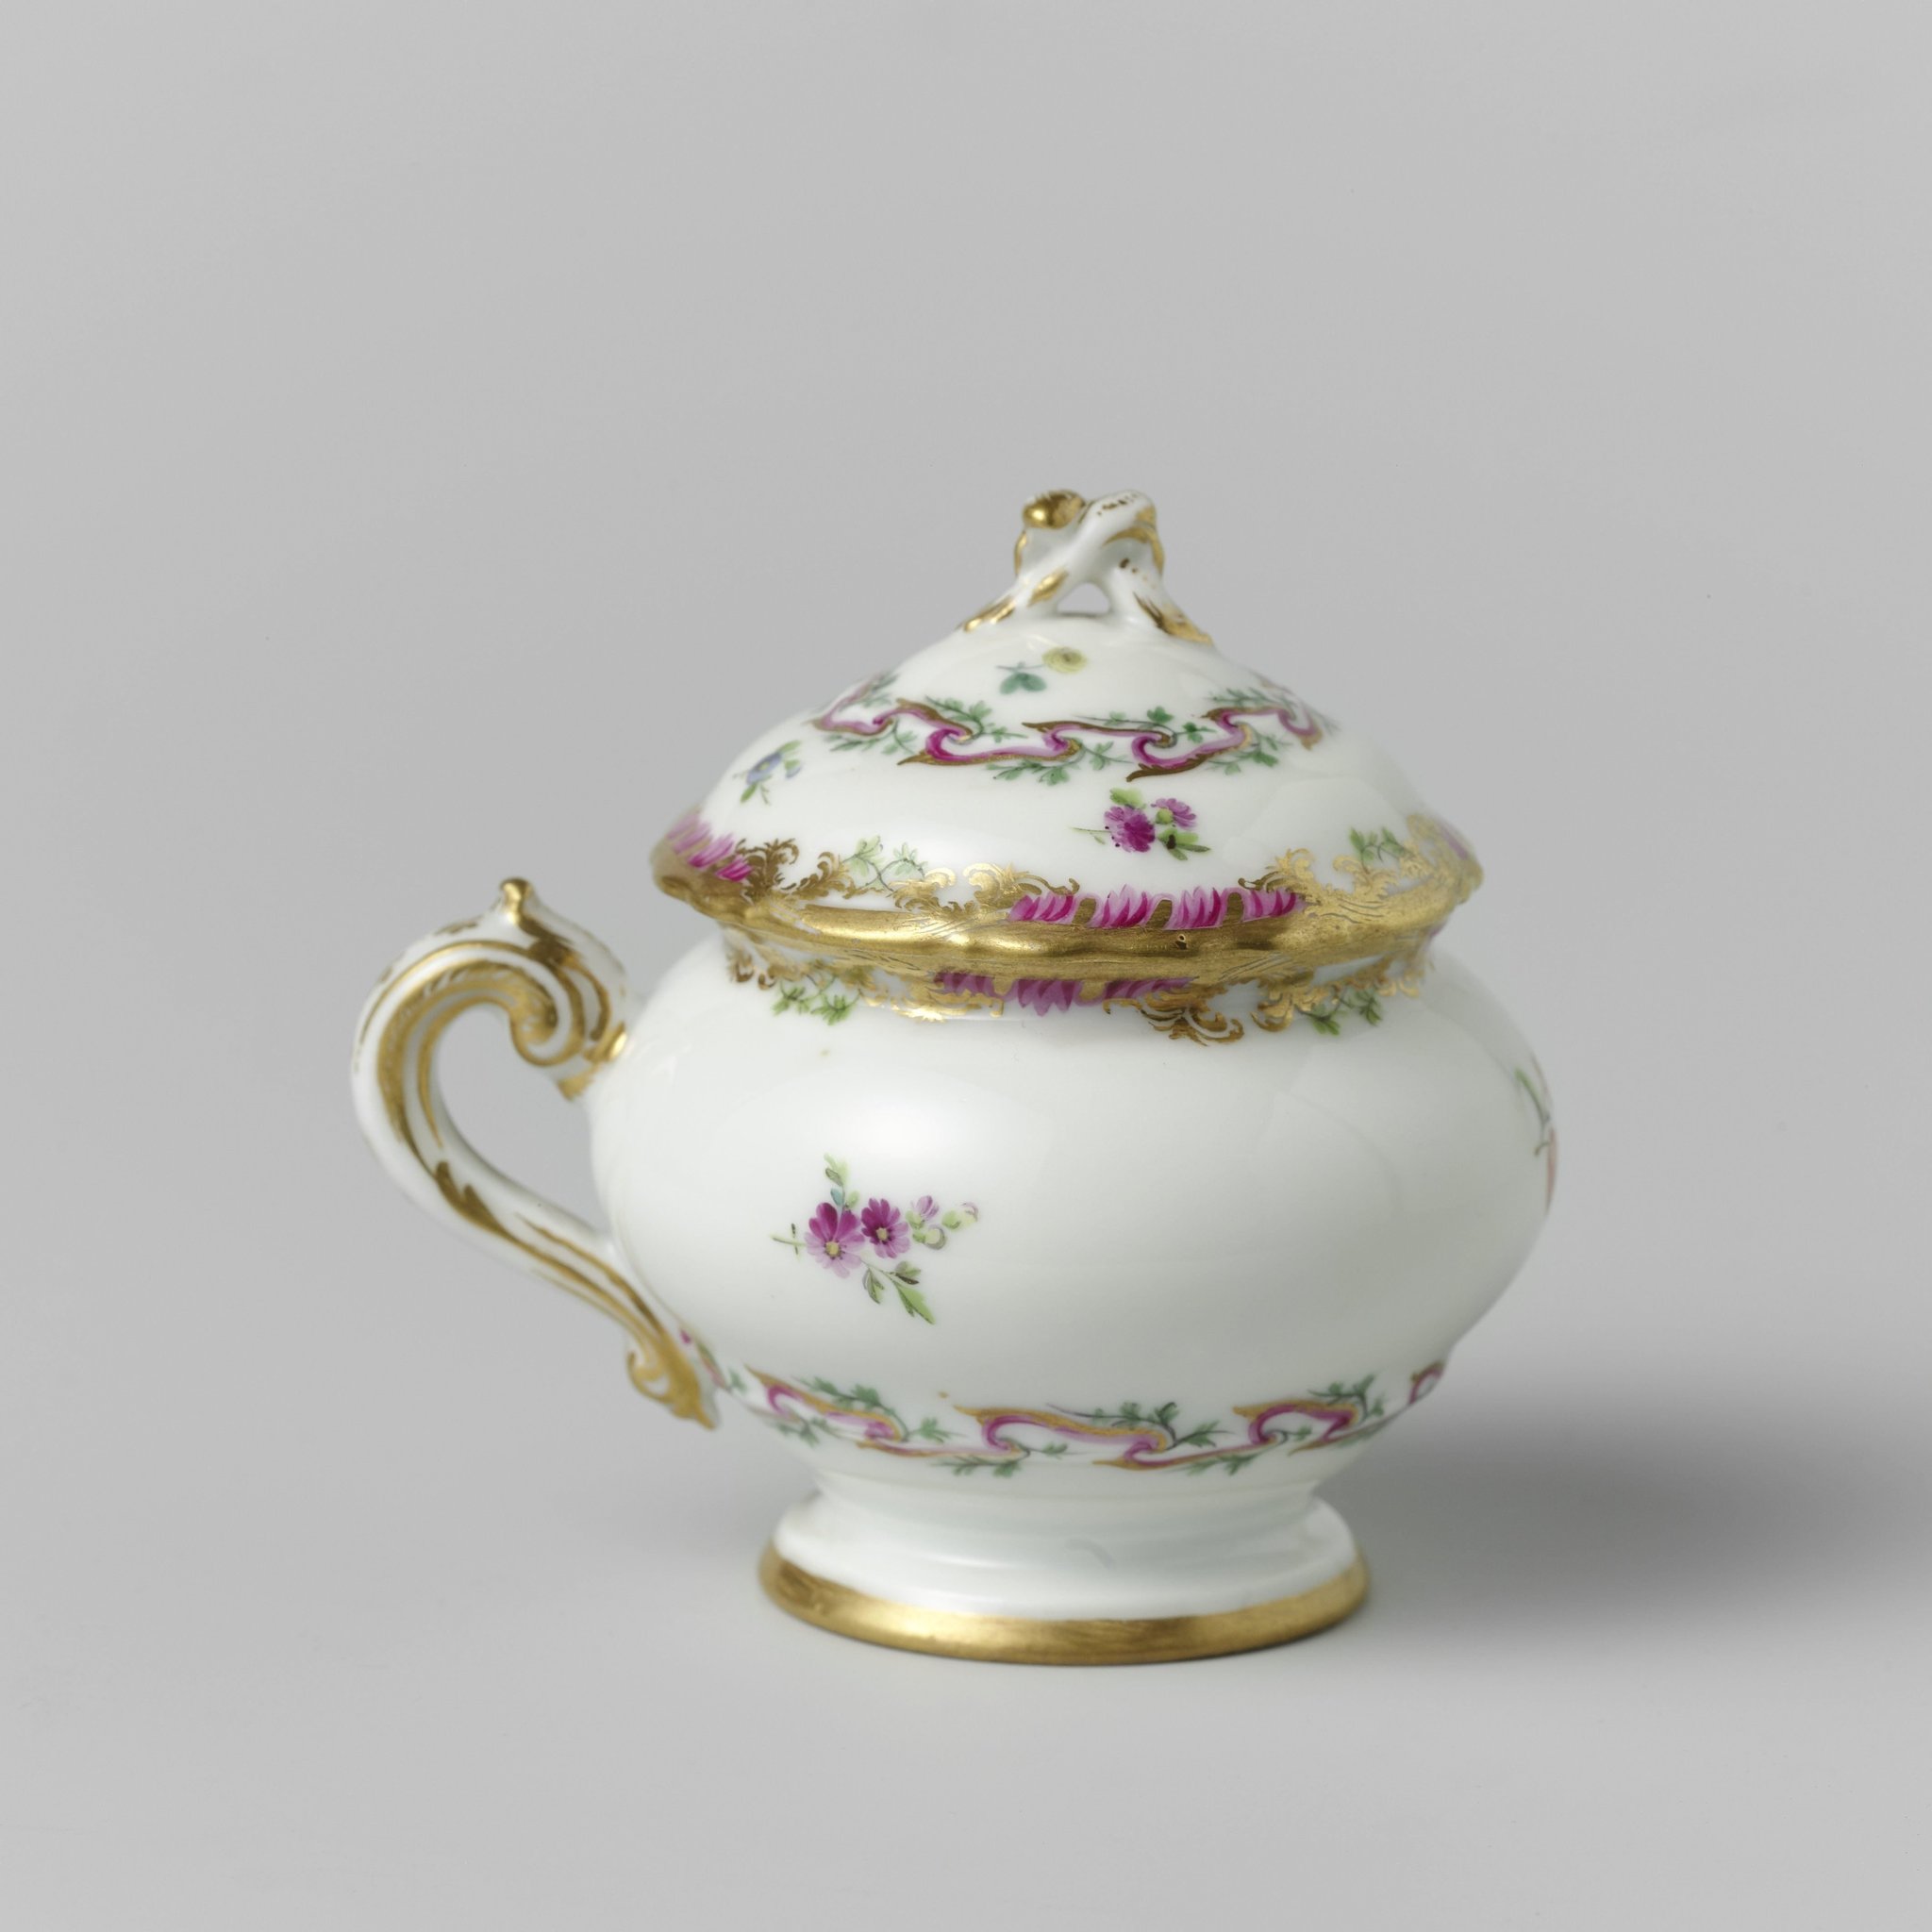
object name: pot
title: Pasteipot,rond,met deksel en oor, behorend bij een servies met geslingerd lintmotief met bladertakken, bloemboeketten en gestrooide bloemtakken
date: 1780-1820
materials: porcelain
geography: amsterdam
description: Pasteipot, rond, met deksel en oor, behorend bij een servies van porselein met geslingerd motief in paars en goud met groene bladertakken, bloemboeketten en gestrooide bloemtakken. Randen lichtgegolfd met decoratie in goud met paars bladmotief waartussen groen gekruist bladmotief. Gemerkt: M.O.L. en AMSTEL. Serie van elf stuks.